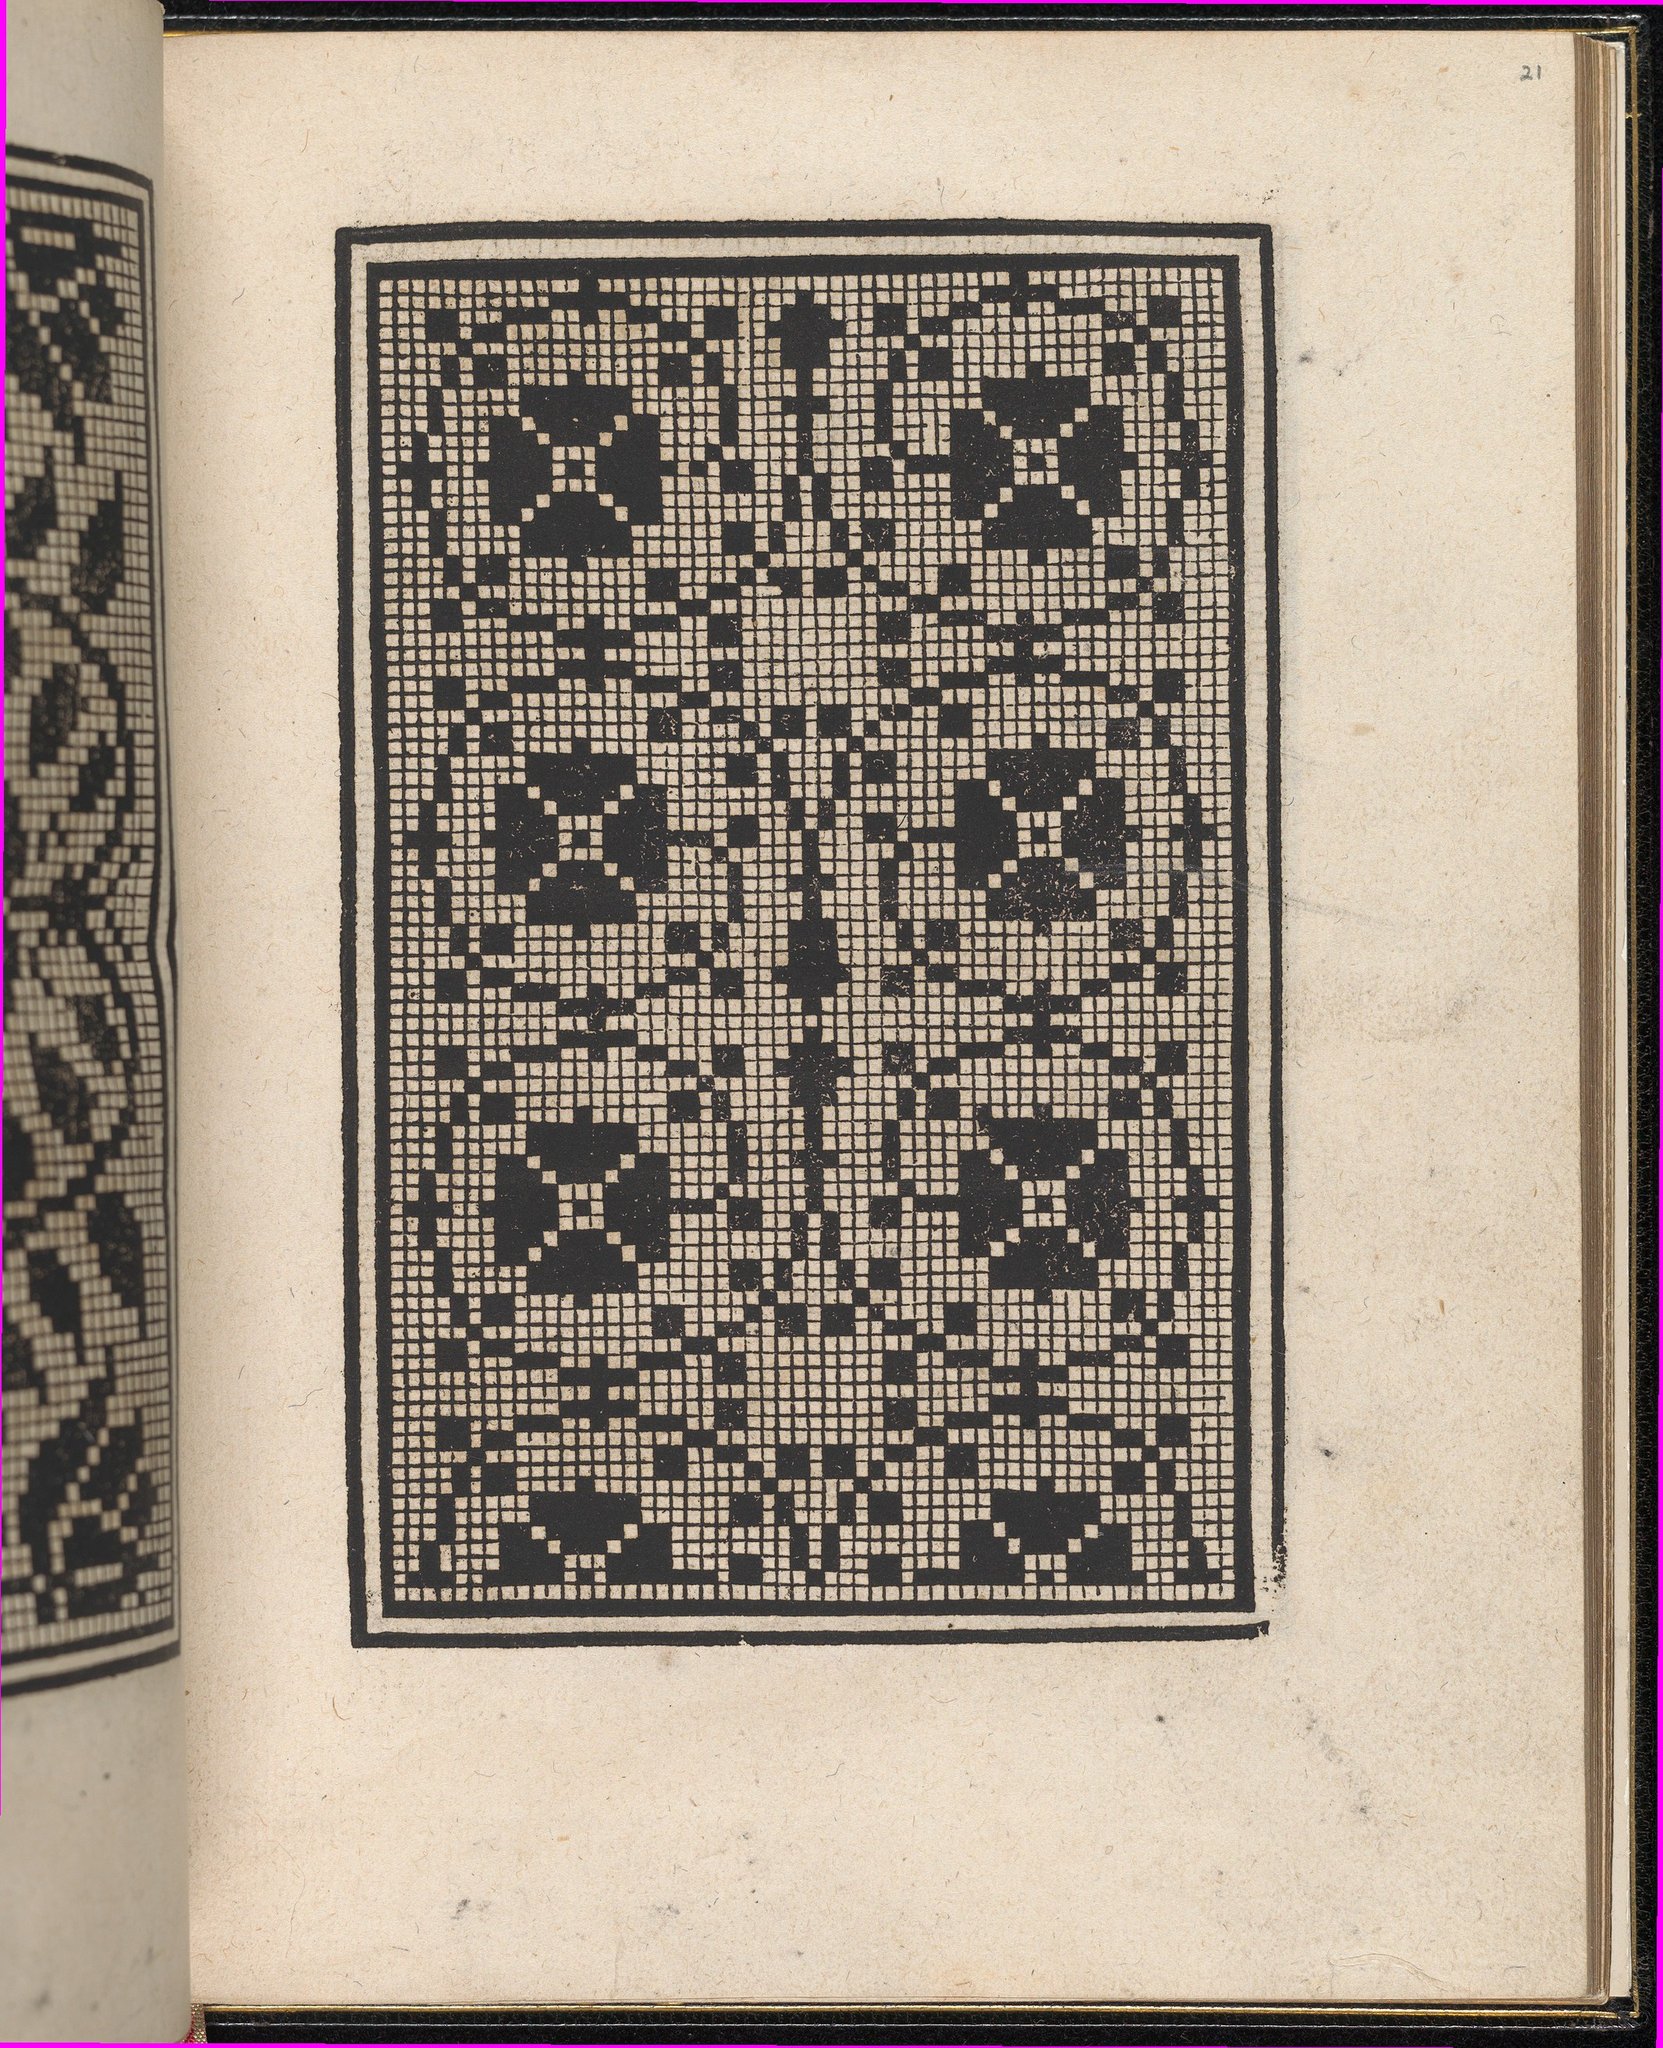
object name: book print ornament architecture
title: Page from Ein new kunstlich Modelbuch...(Page 21r)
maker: peter quentel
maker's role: publisher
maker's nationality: german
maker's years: 1500-1550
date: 1544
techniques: woodcut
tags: ornament